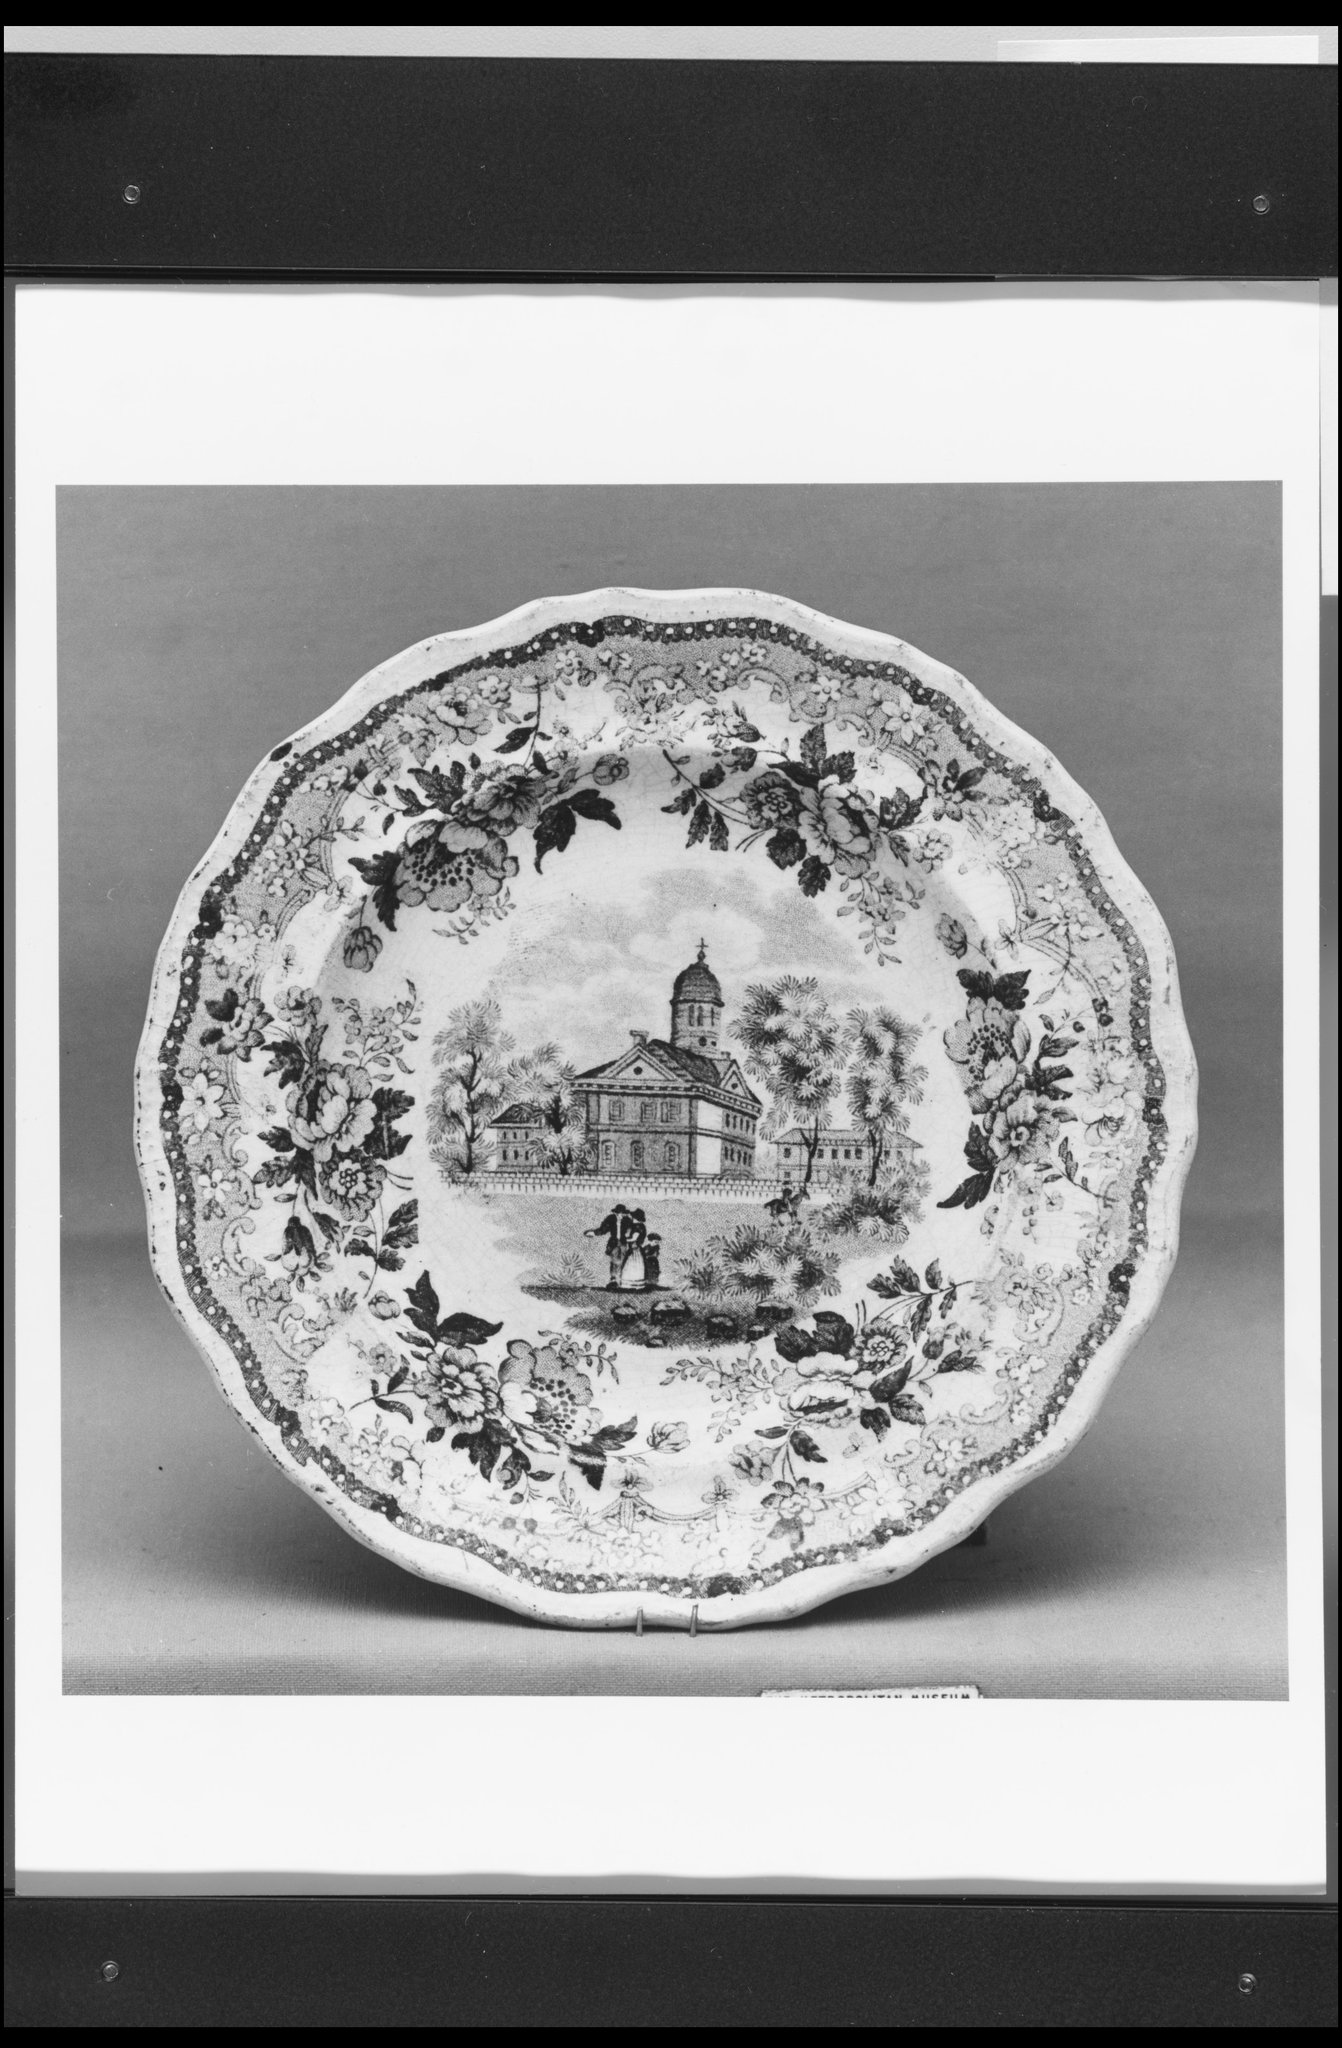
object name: plate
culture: british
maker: job & john jackson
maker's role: maker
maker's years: 1831-1835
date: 1831-1835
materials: earthenware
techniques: transfer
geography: england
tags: buildings,flowers